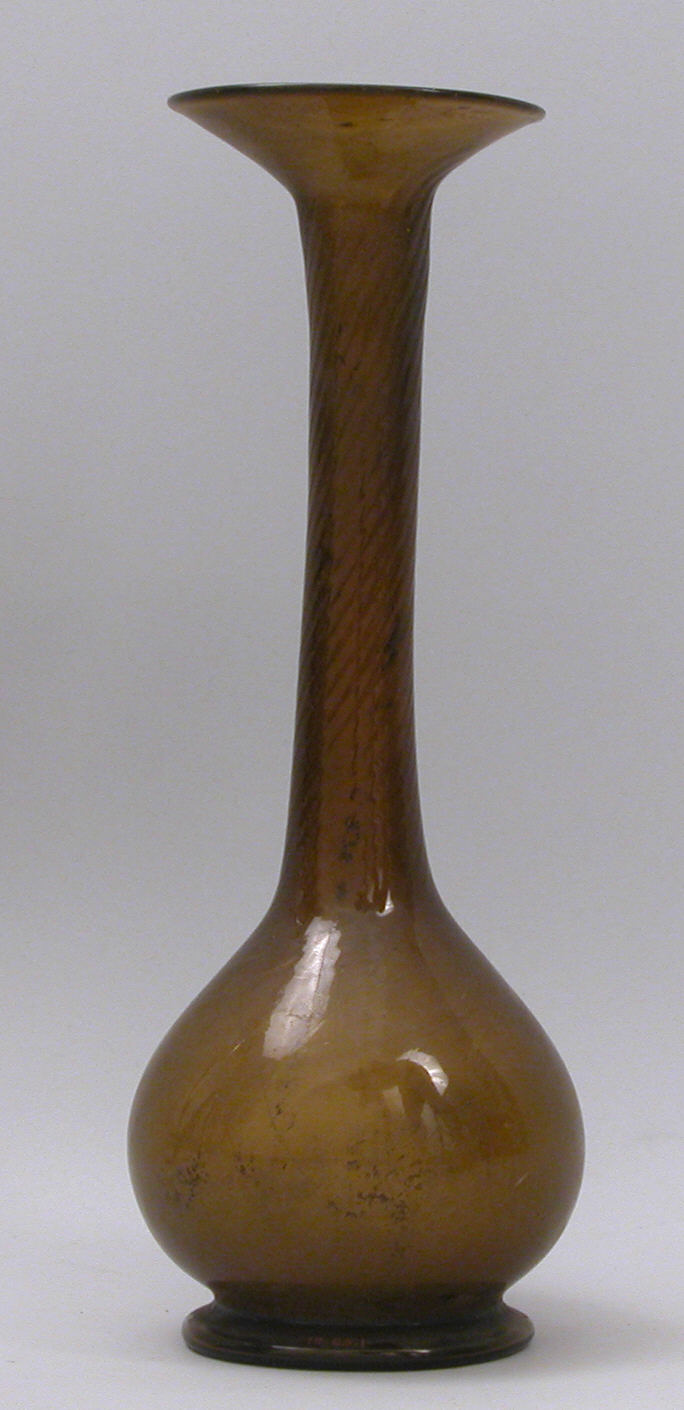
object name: bottle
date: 1701-1900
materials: glass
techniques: glassblowing, tooling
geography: iran